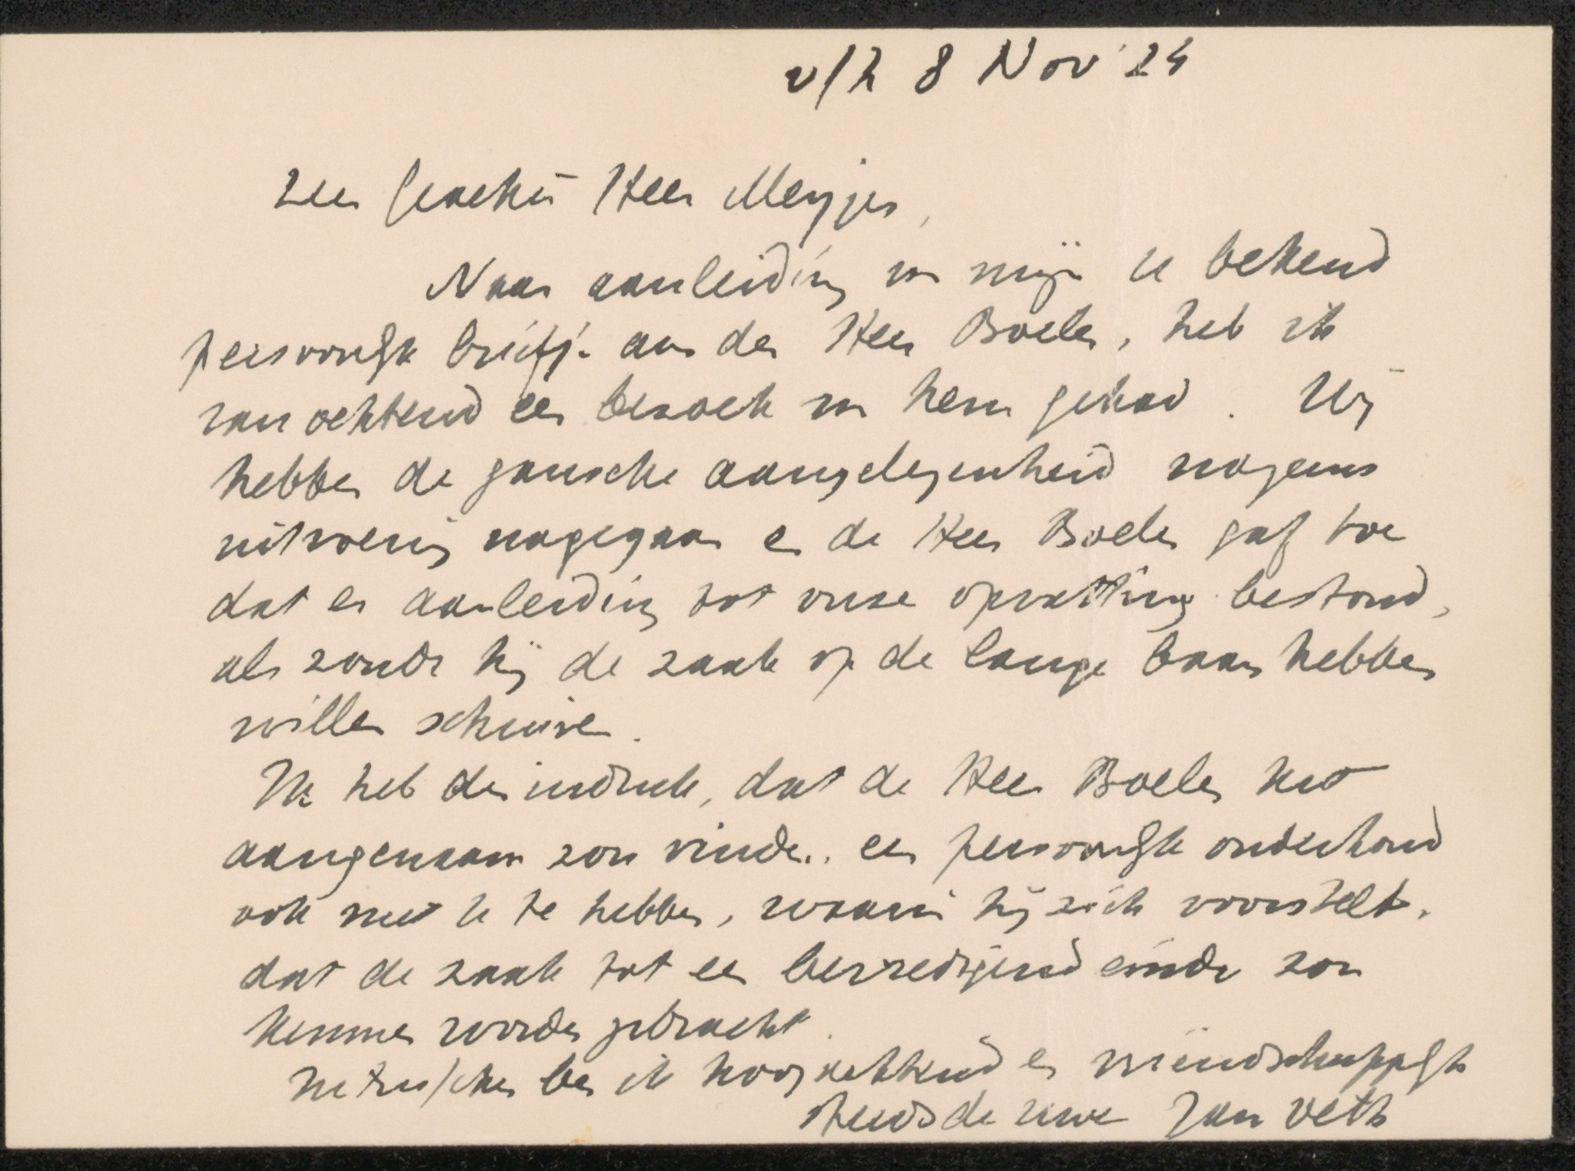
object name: letter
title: Brief aan F.E. Posthumus Meyjes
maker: jan veth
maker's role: designer, draughtsman, painter, print maker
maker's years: 1864-1925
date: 1924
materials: ink, paper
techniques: pen, writing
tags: f.e. posthumus meyjes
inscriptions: collector's mark: ‘RPK’